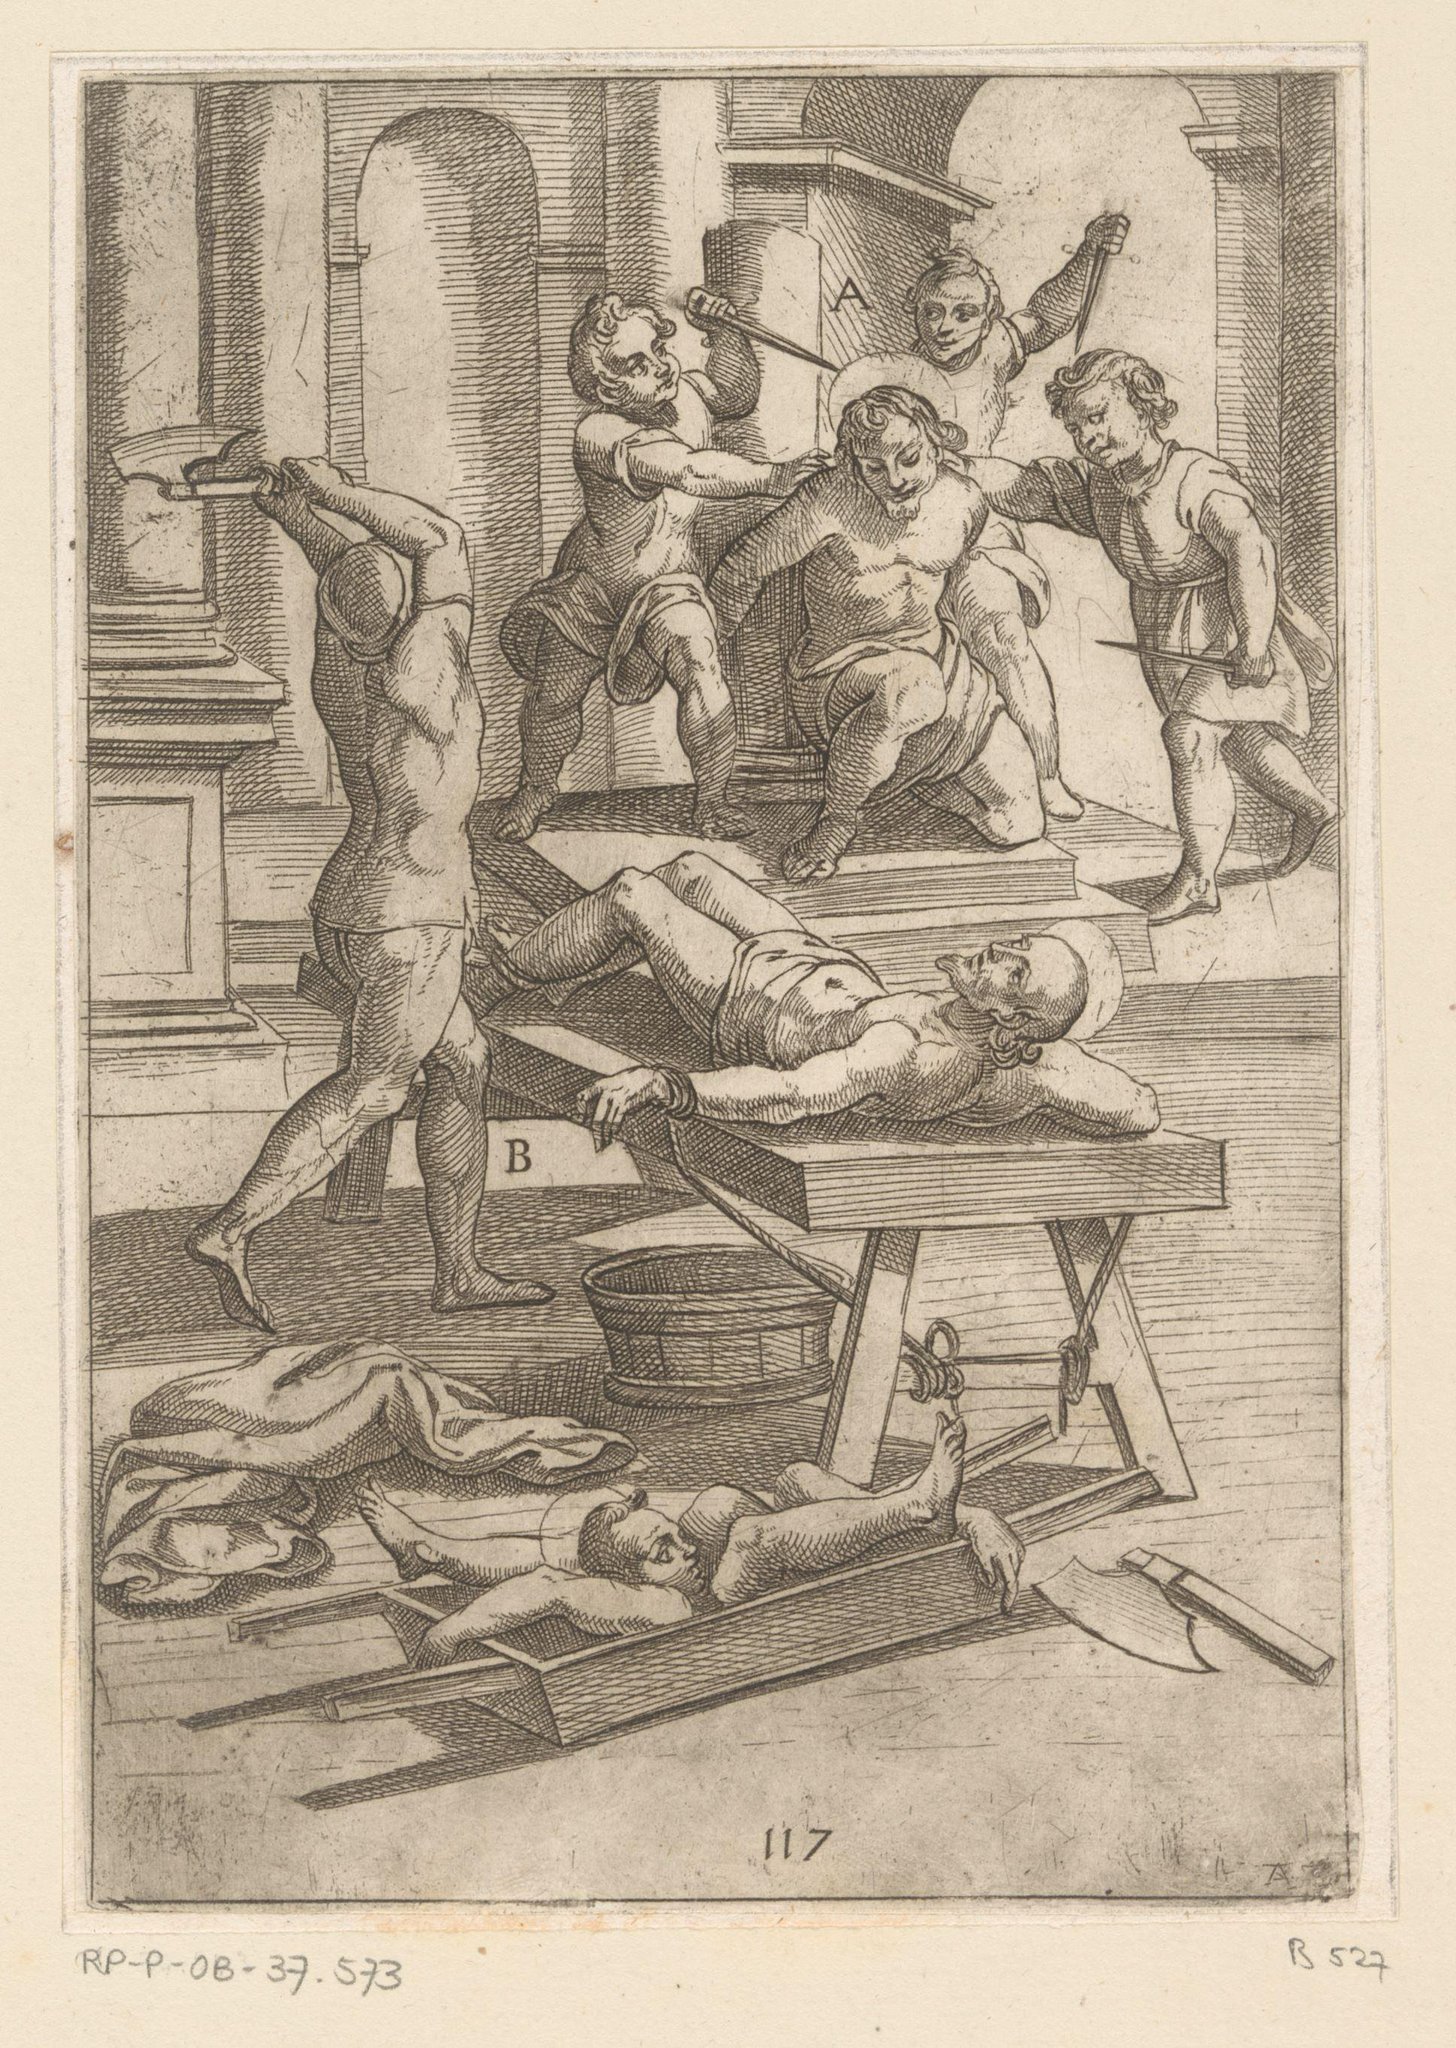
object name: print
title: Varia tormentorum et supplicioru crudelium (...)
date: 1565-1630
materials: paper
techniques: etching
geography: vatican city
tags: violent death ~ maltreatment, torture, torture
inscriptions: collector's mark: Lugt 240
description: Deze prent maakt deel uit van een reeks van 47 prenten (+ titelprent) met voorstellingen van martelmethoden. Deze prenten zijn in een andere editie gebruikt als illustraties voor Antonio Gallonio's 'Trattato degli Instrumenti di Martirio e delle Varie Maniere di Martoriare Usate dai Gentili contro Christiani' (Rome, Ascanio en Girolamo Dongangeli, 1591).